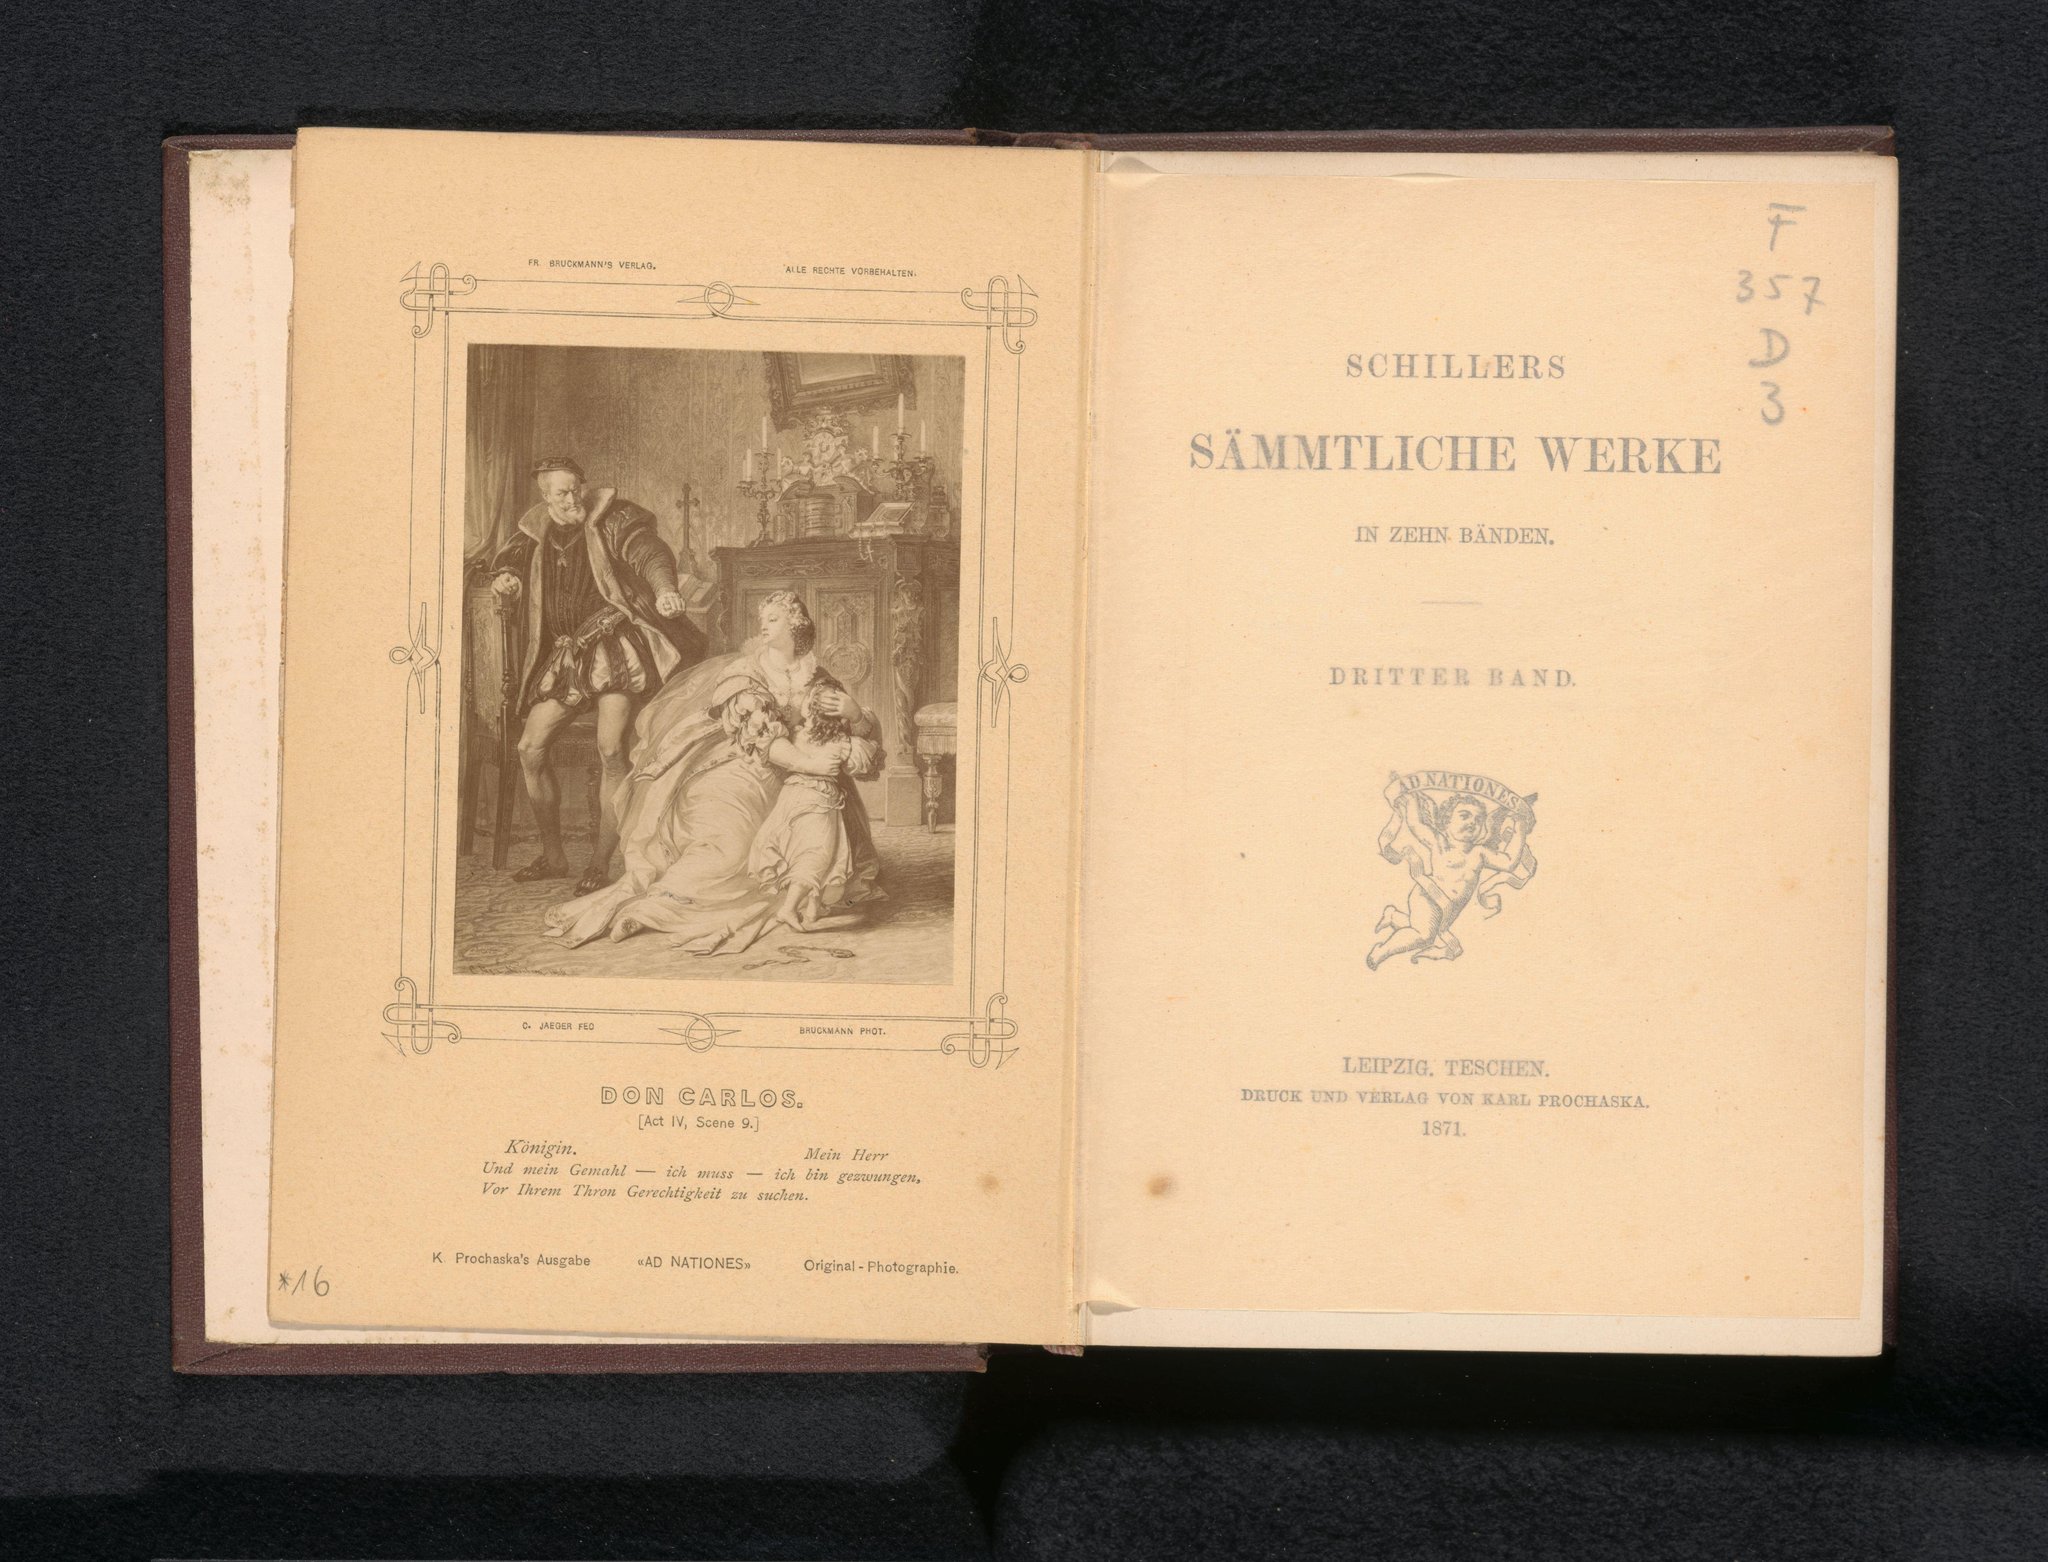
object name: reproduction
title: Don Carlos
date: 1861-1871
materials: photographic support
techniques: albumen print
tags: mother and baby or young child, specific works of literature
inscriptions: inscription: ‘[Act IV, Scene 9.] Königin Mein Herr (...) Gerechtigkeit zu suchen.’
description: Te zien is vermoedelijk Filips II en een vrouw met een kind.